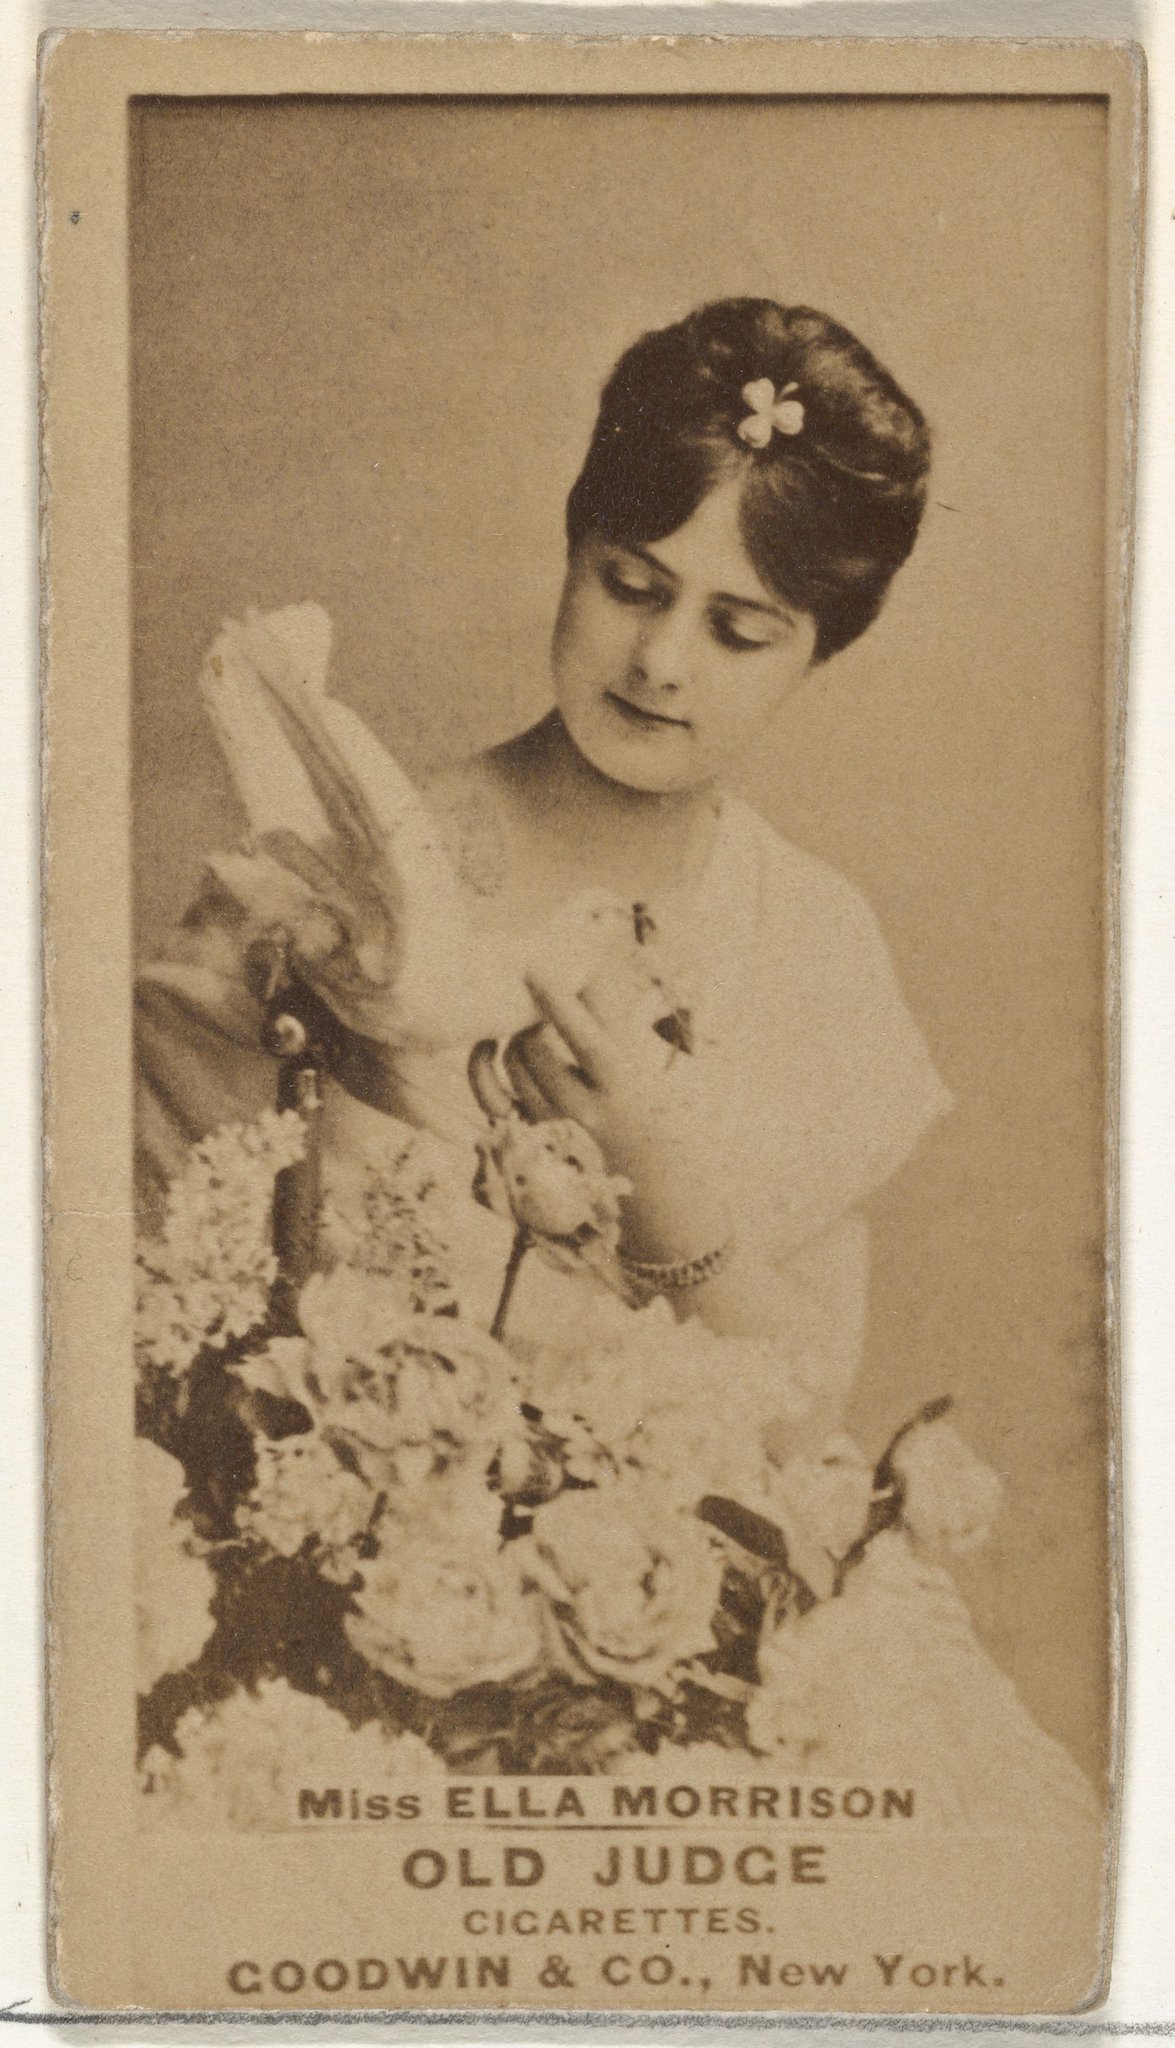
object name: photograph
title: Miss Ella Morrison, from the Actors and Actresses series (N171) for Old Judge Cigarettes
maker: goodwin & company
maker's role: publisher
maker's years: 1850-1950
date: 1886-1890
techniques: albumen silver print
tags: birds,portraits,women,actresses